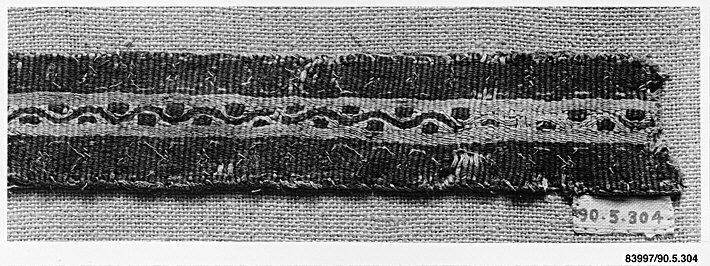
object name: textile fragment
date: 201-400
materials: linen, wool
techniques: weave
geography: egypt